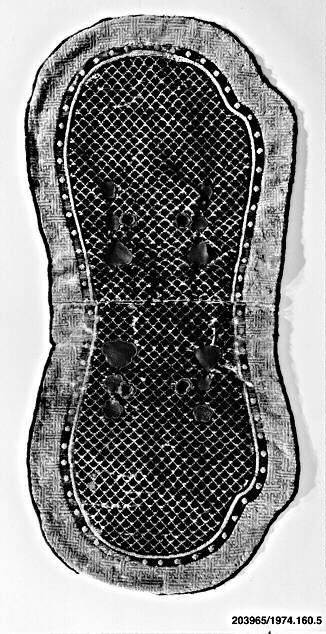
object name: rug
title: Saddle Rug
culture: chinese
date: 1701-1800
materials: cotton, wool